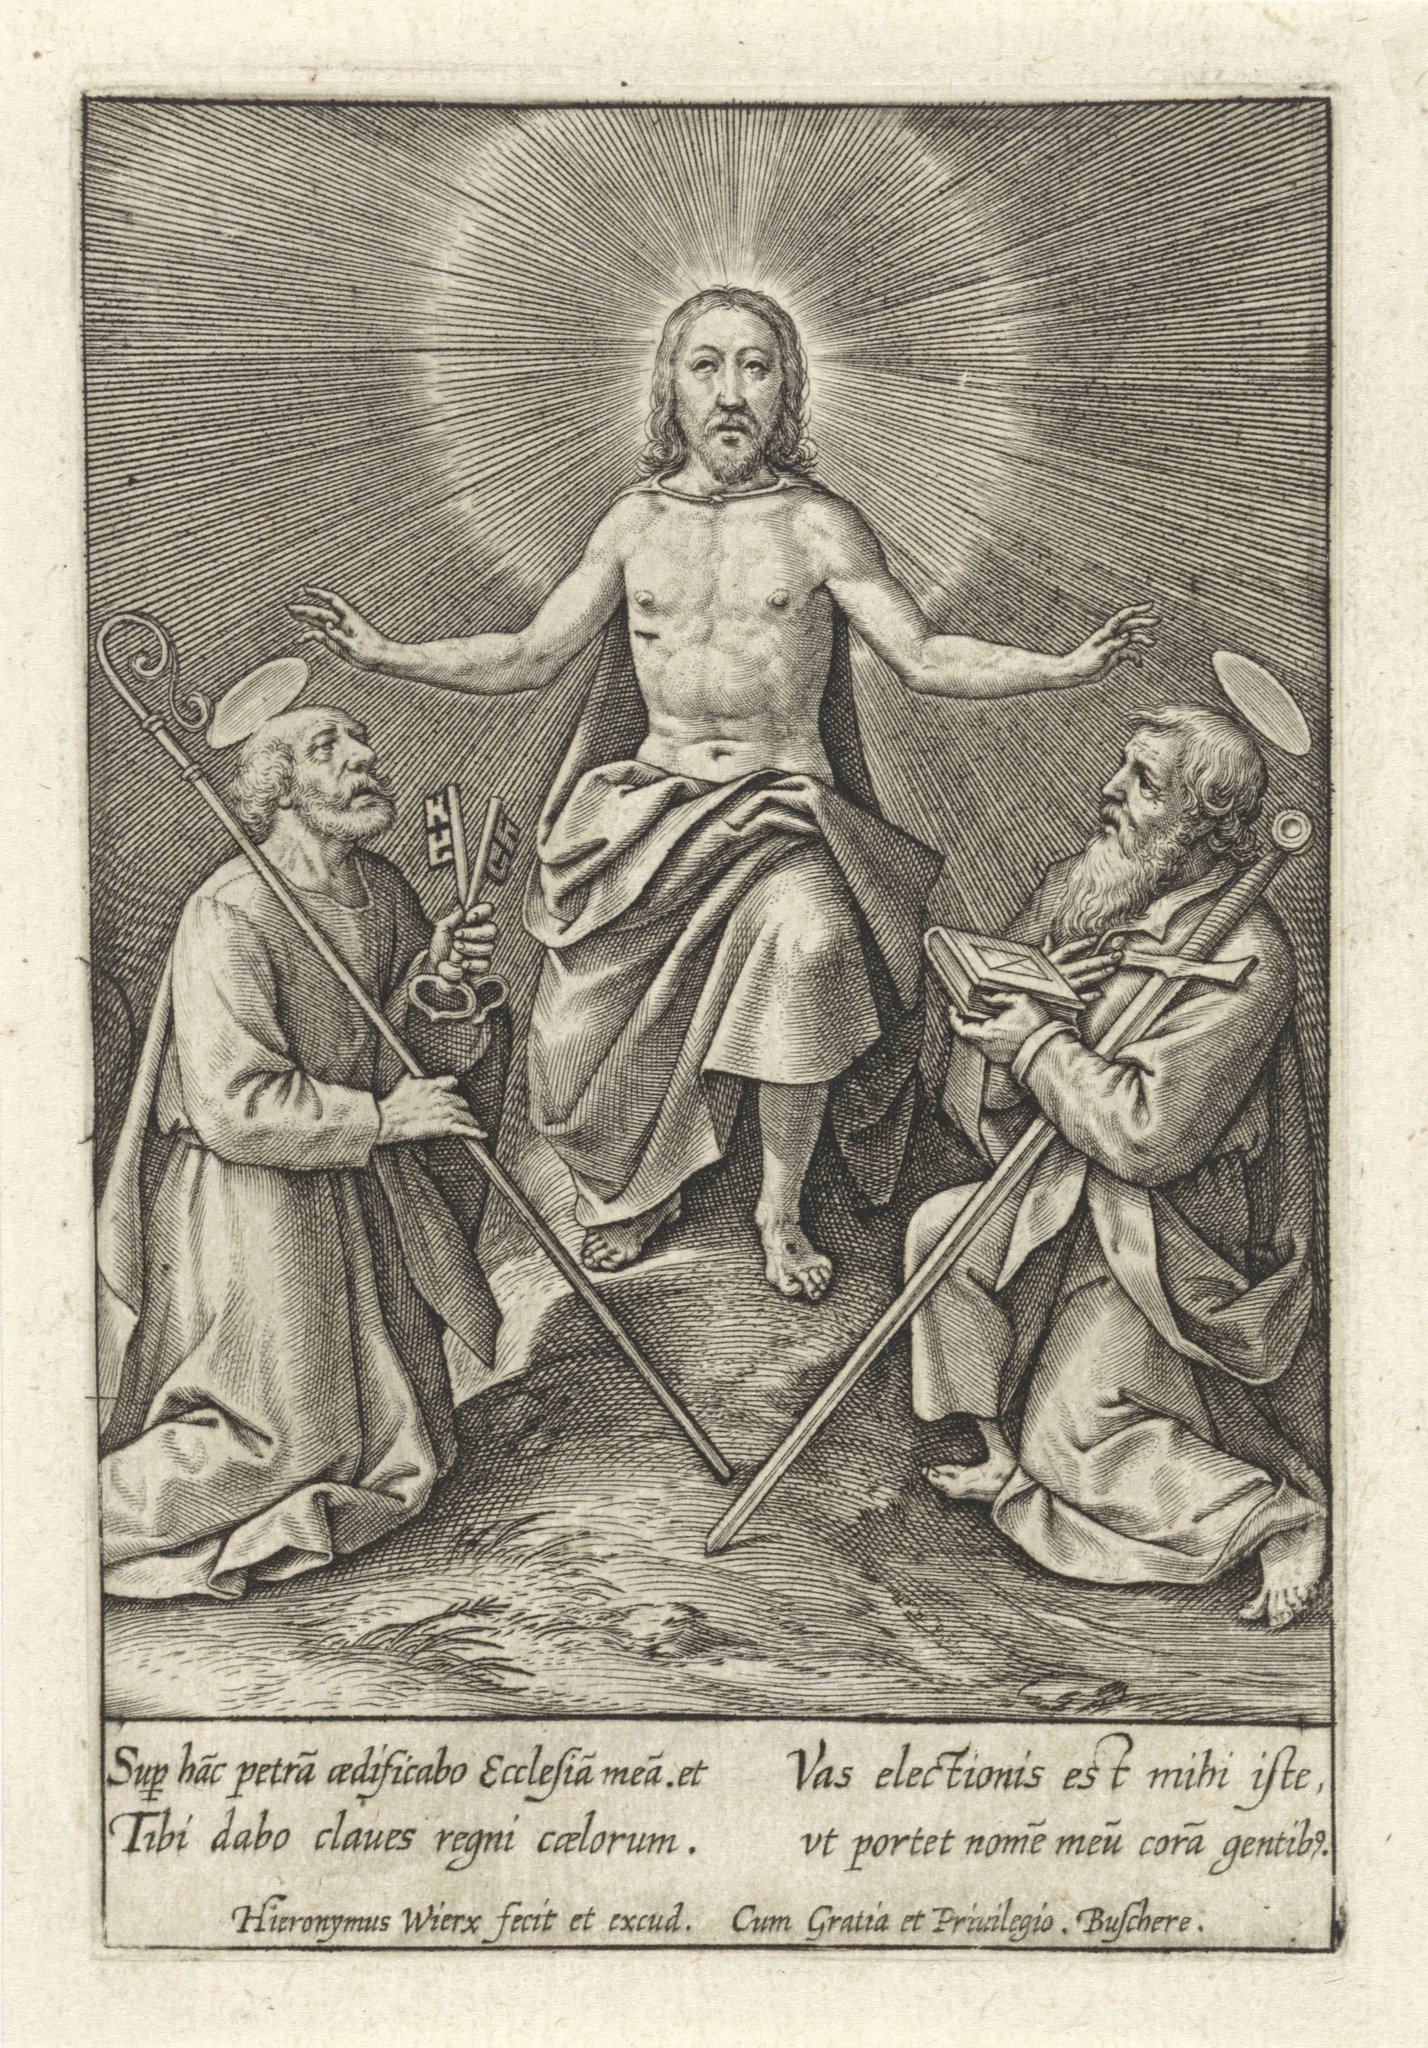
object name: print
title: Herrezen Christus met Petrus en Paulus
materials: paper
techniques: engraving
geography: antwerp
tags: appearances of christ after the resurrection, the apostle peter, first bishop of rome; possible attributes: book, cock, (upturned) cross, (triple) crozier, fish, key, scroll, ship, tiara, the apostle paul of tarsus; possible attributes: book, scroll, sword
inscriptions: collector's mark: Lugt 2228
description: Petrus en Paulus knielen in aanbidding voor de herrezen Christus. Hij zegent hen, zittend op een heuveltje. In de marge een vierregelig onderschrift, in twee kolommen, in het Latijn.